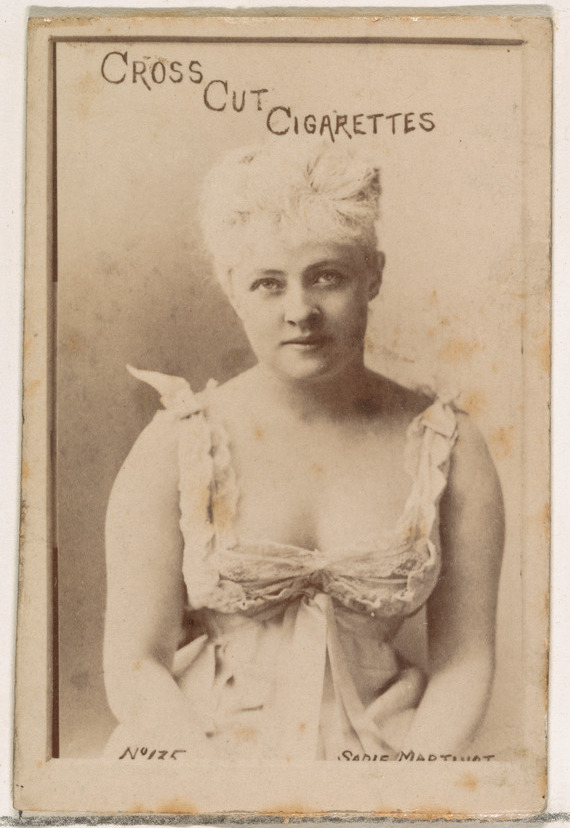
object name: print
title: Card Number 135, Sadie Martinot, from the Actors and Actresses series (N145-1) issued by Duke Sons & Co. to promote Cross Cut Cigarettes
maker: w. duke, sons & co.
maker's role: publisher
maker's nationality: american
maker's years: 1870-1920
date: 1880-1889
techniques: albumen silver print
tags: portraits,women,actresses